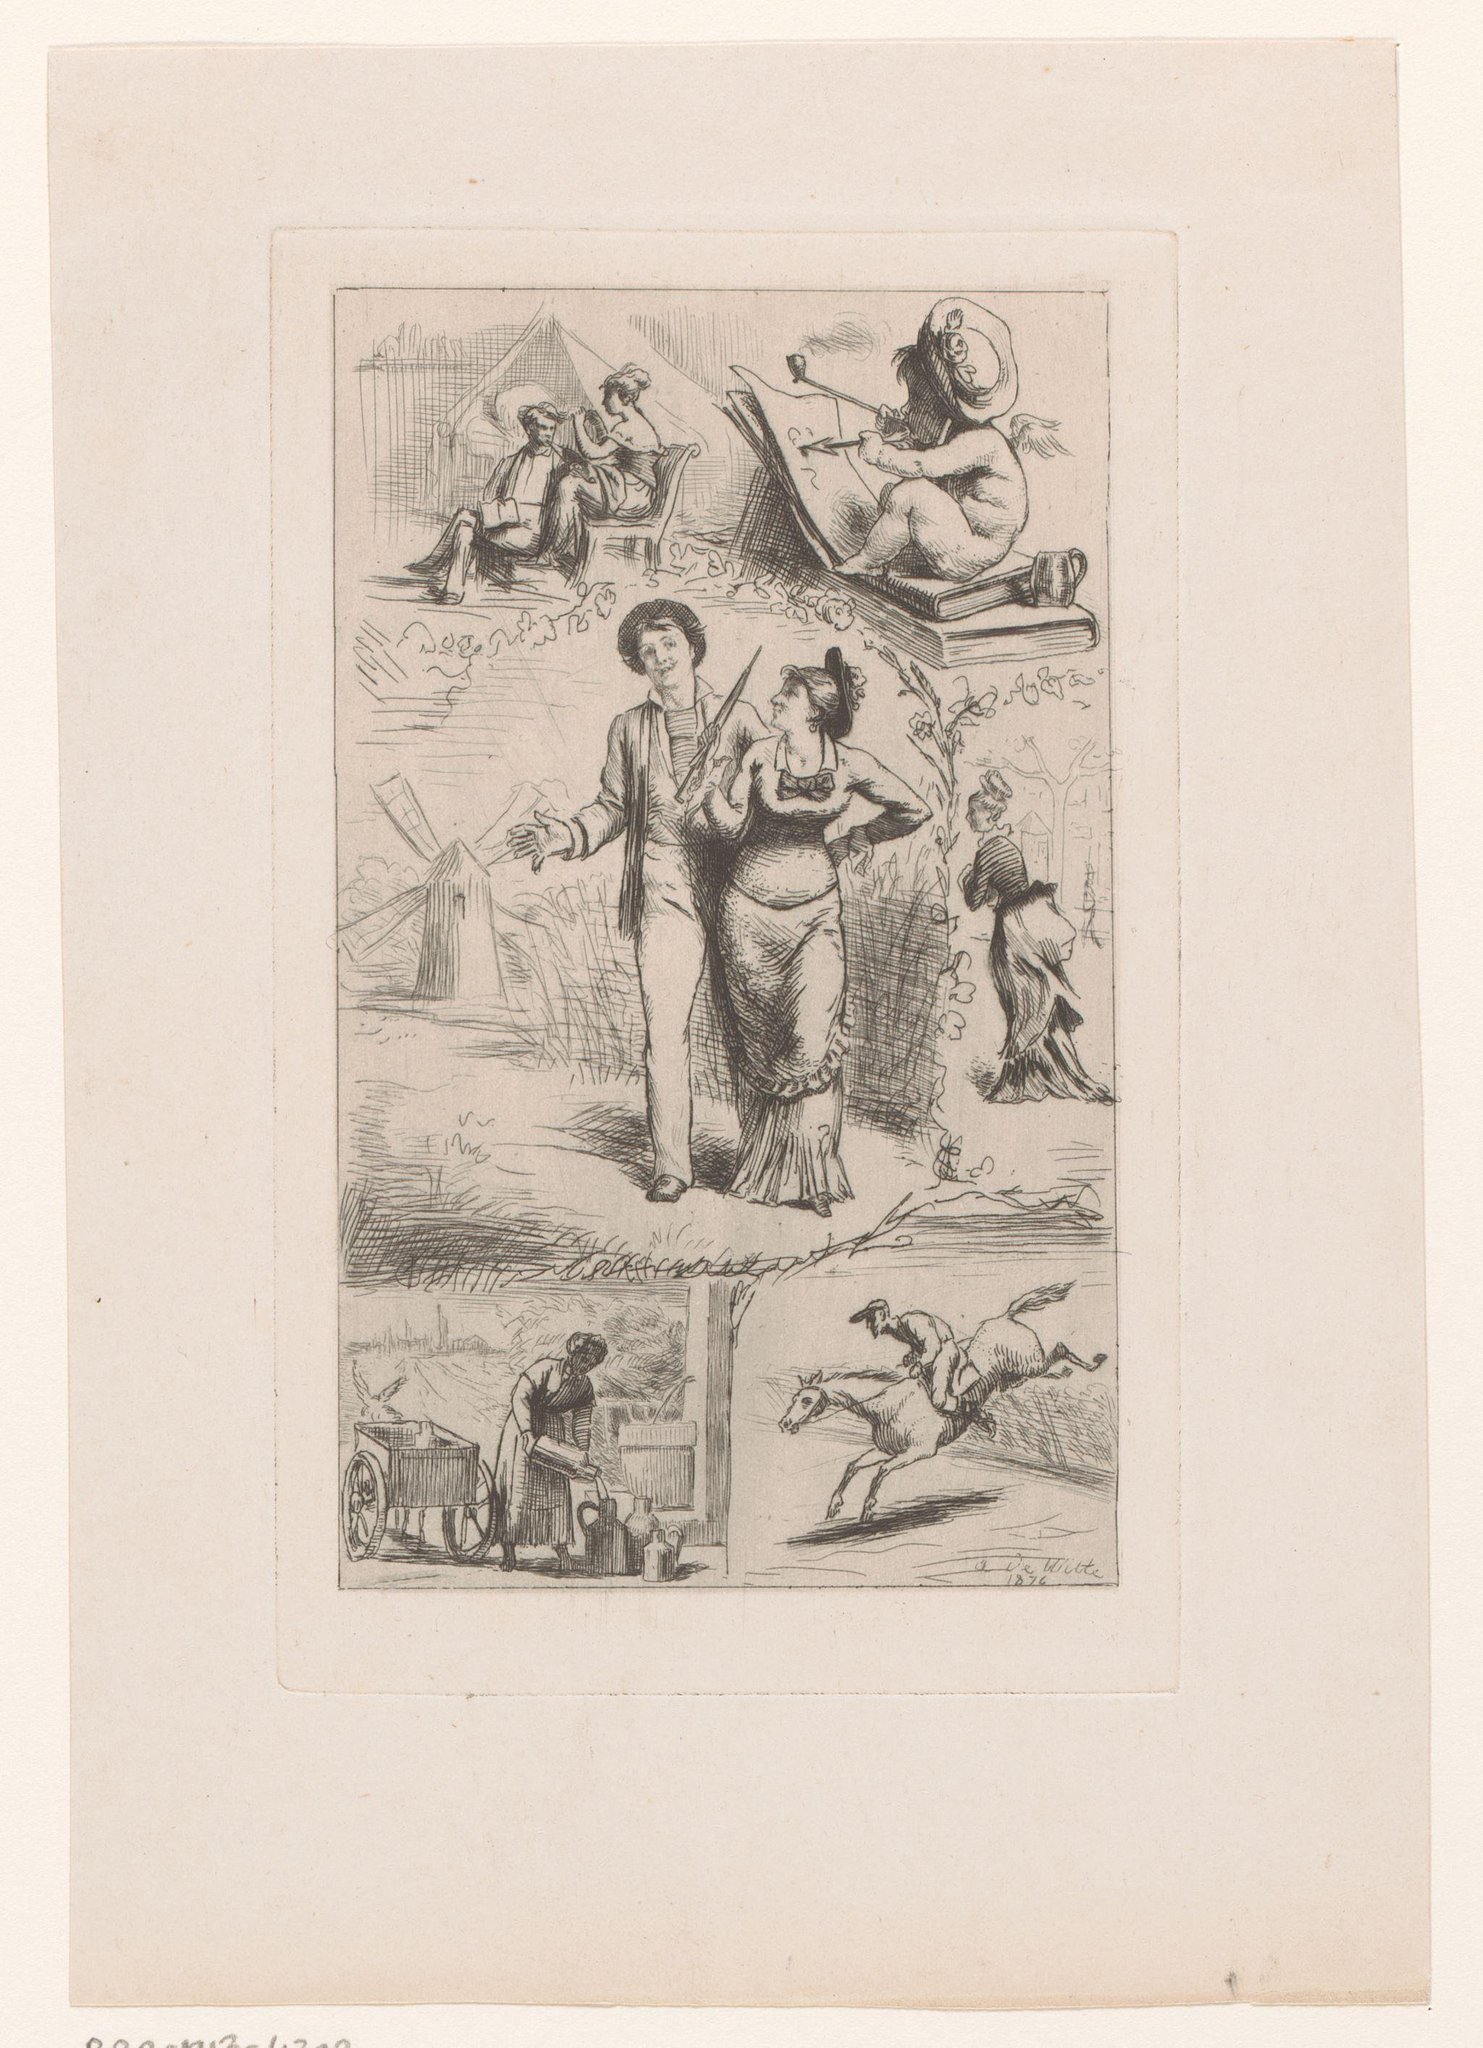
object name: print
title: Koppel wandelend bij een molen met rondom diverse voorstellingen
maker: adrien de witte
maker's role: print maker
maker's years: 1850-1935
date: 1876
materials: paper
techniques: drypoint, etching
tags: windmill in landscape, (story of) cupid, amor (eros), horse-racing, milkmaid, couple of lovers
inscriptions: collector's mark: Lugt 2228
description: Mogelijk is deze prent gebruikt als titelprent voor: Backer, H. de. Contes et rythmes. S.l.s.n., 1876.